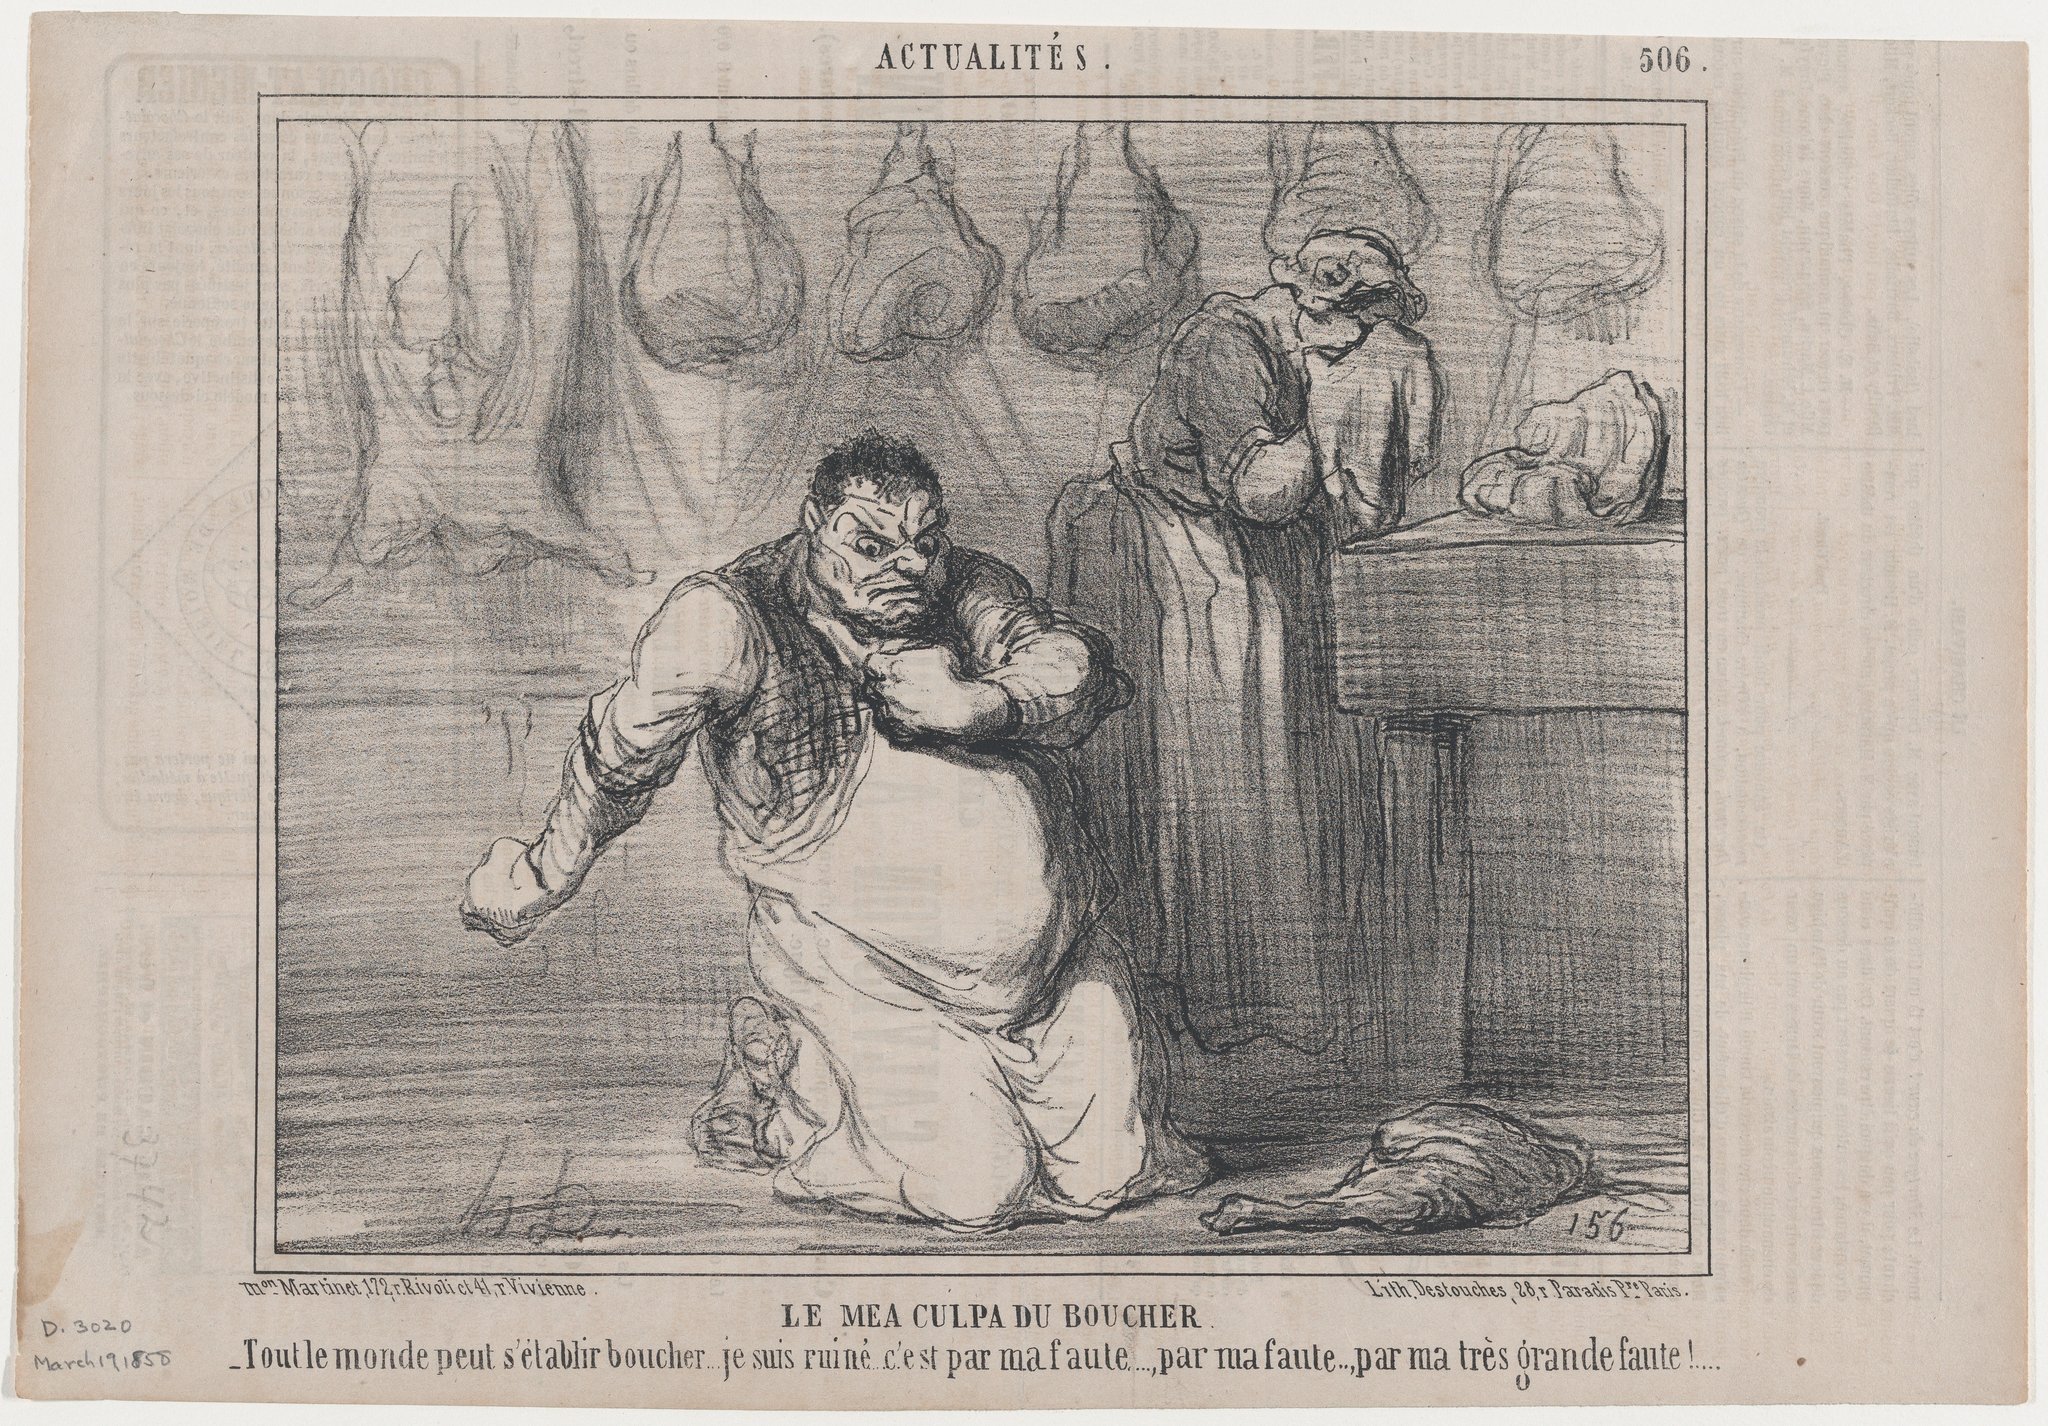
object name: print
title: Le mea culpa du boucher, from Actualités, published in Le Charivari, March 19, 1858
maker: honoré daumier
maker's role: artist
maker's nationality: french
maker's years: 1808-1879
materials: paper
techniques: lithograph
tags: men,women,butchers